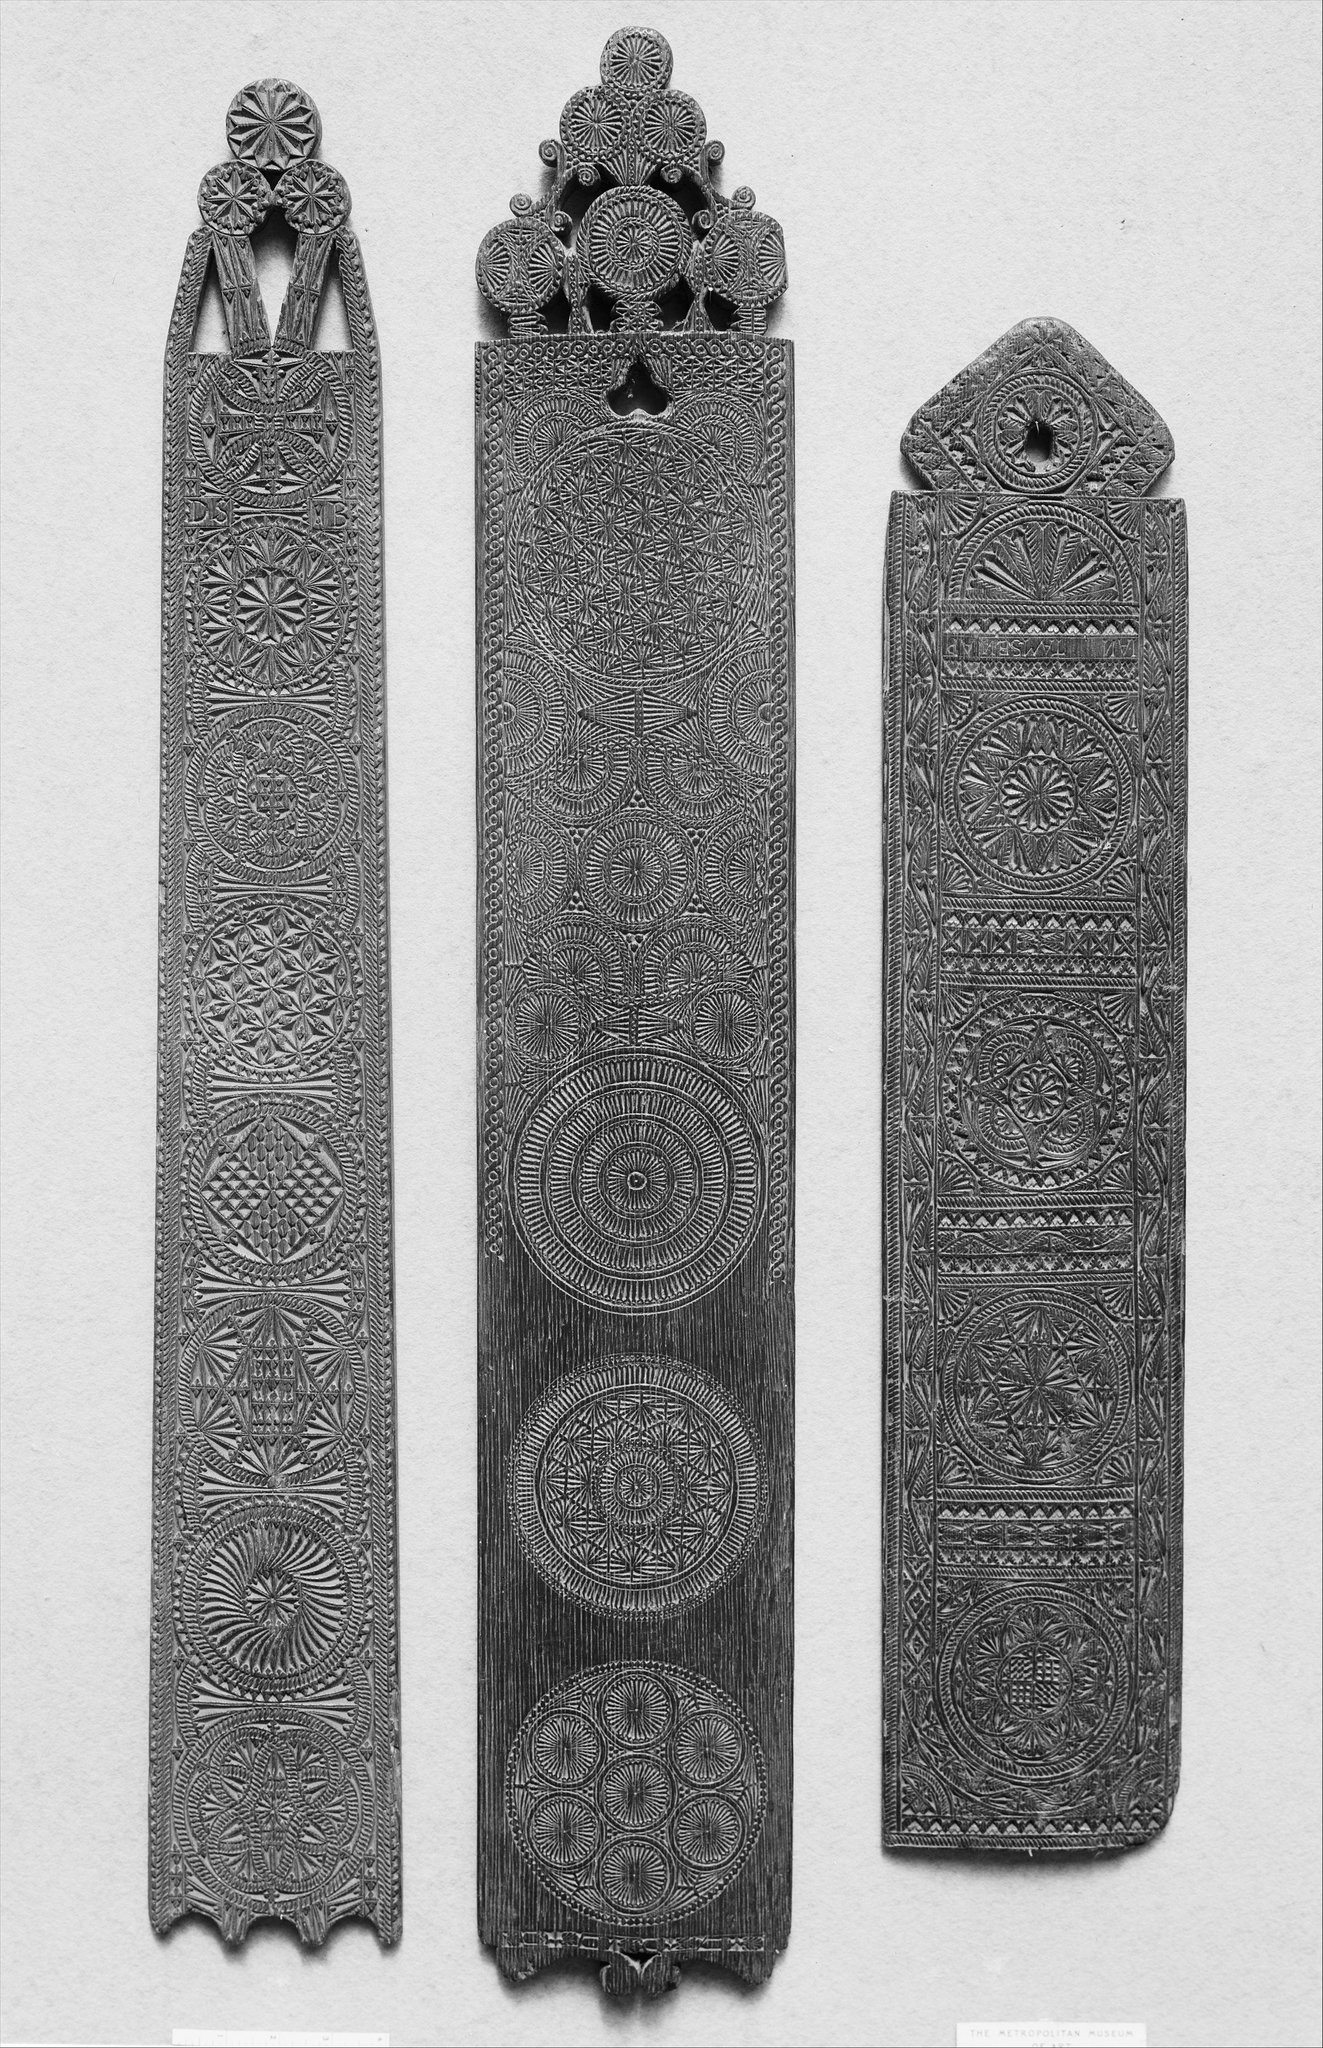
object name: mangle board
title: Mangle-board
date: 1701-1800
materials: wood